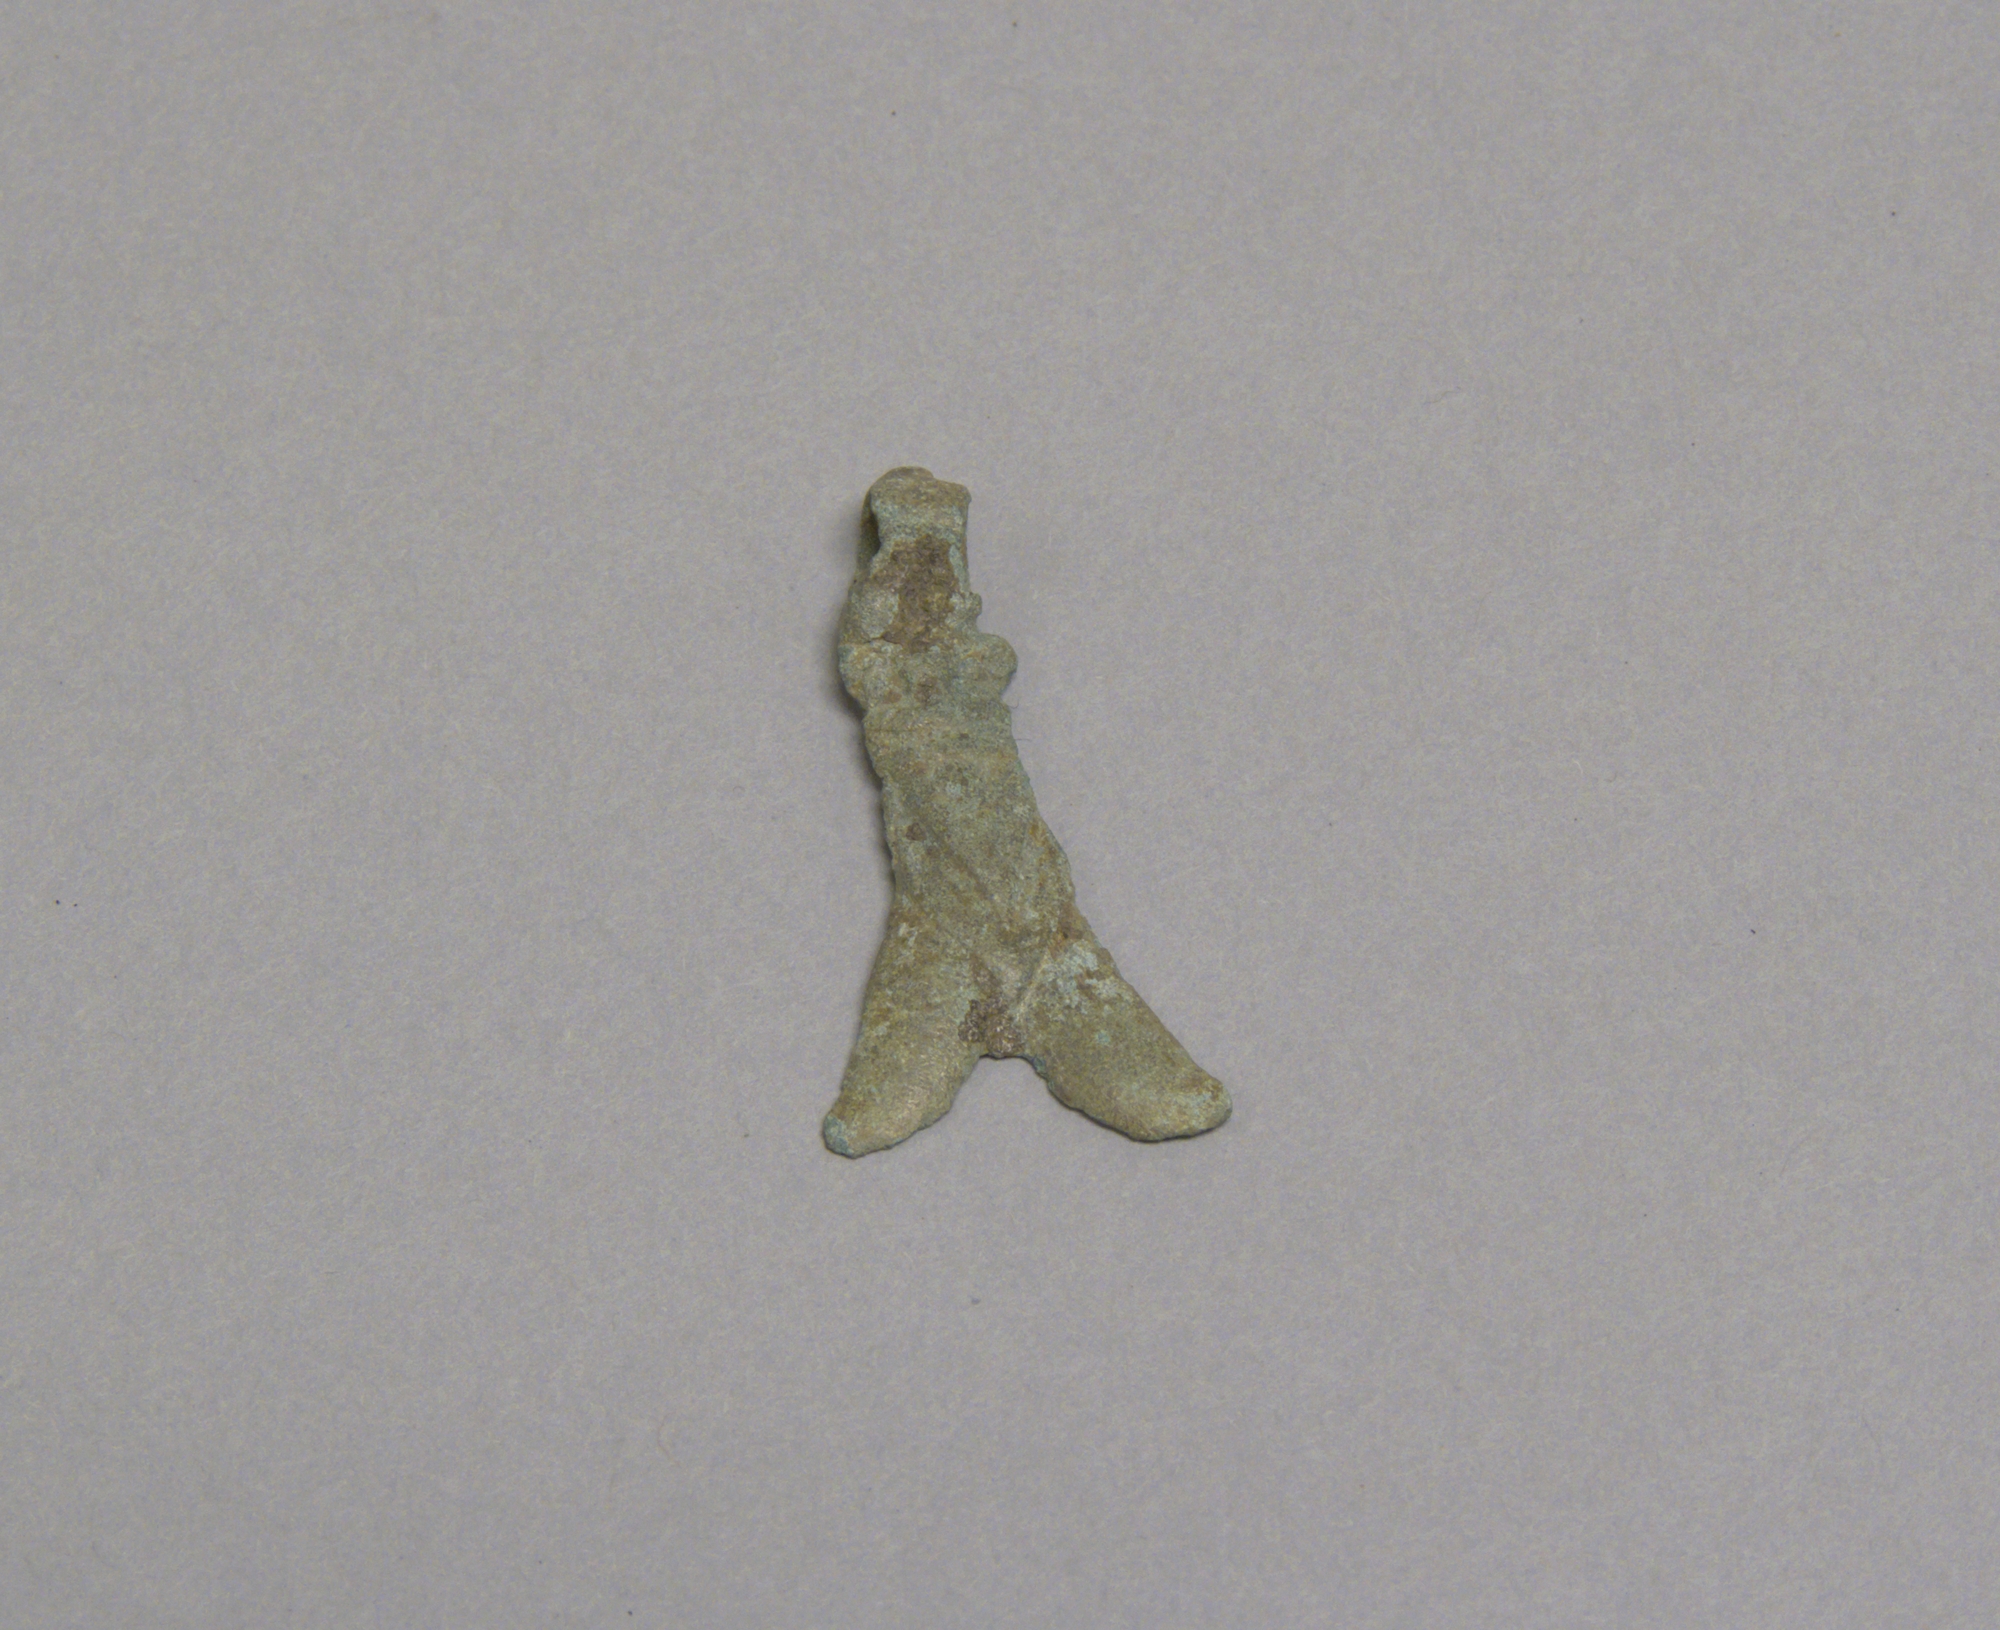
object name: miniature weapon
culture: indonesian, javanese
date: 500 BCE-300 CE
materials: bronze